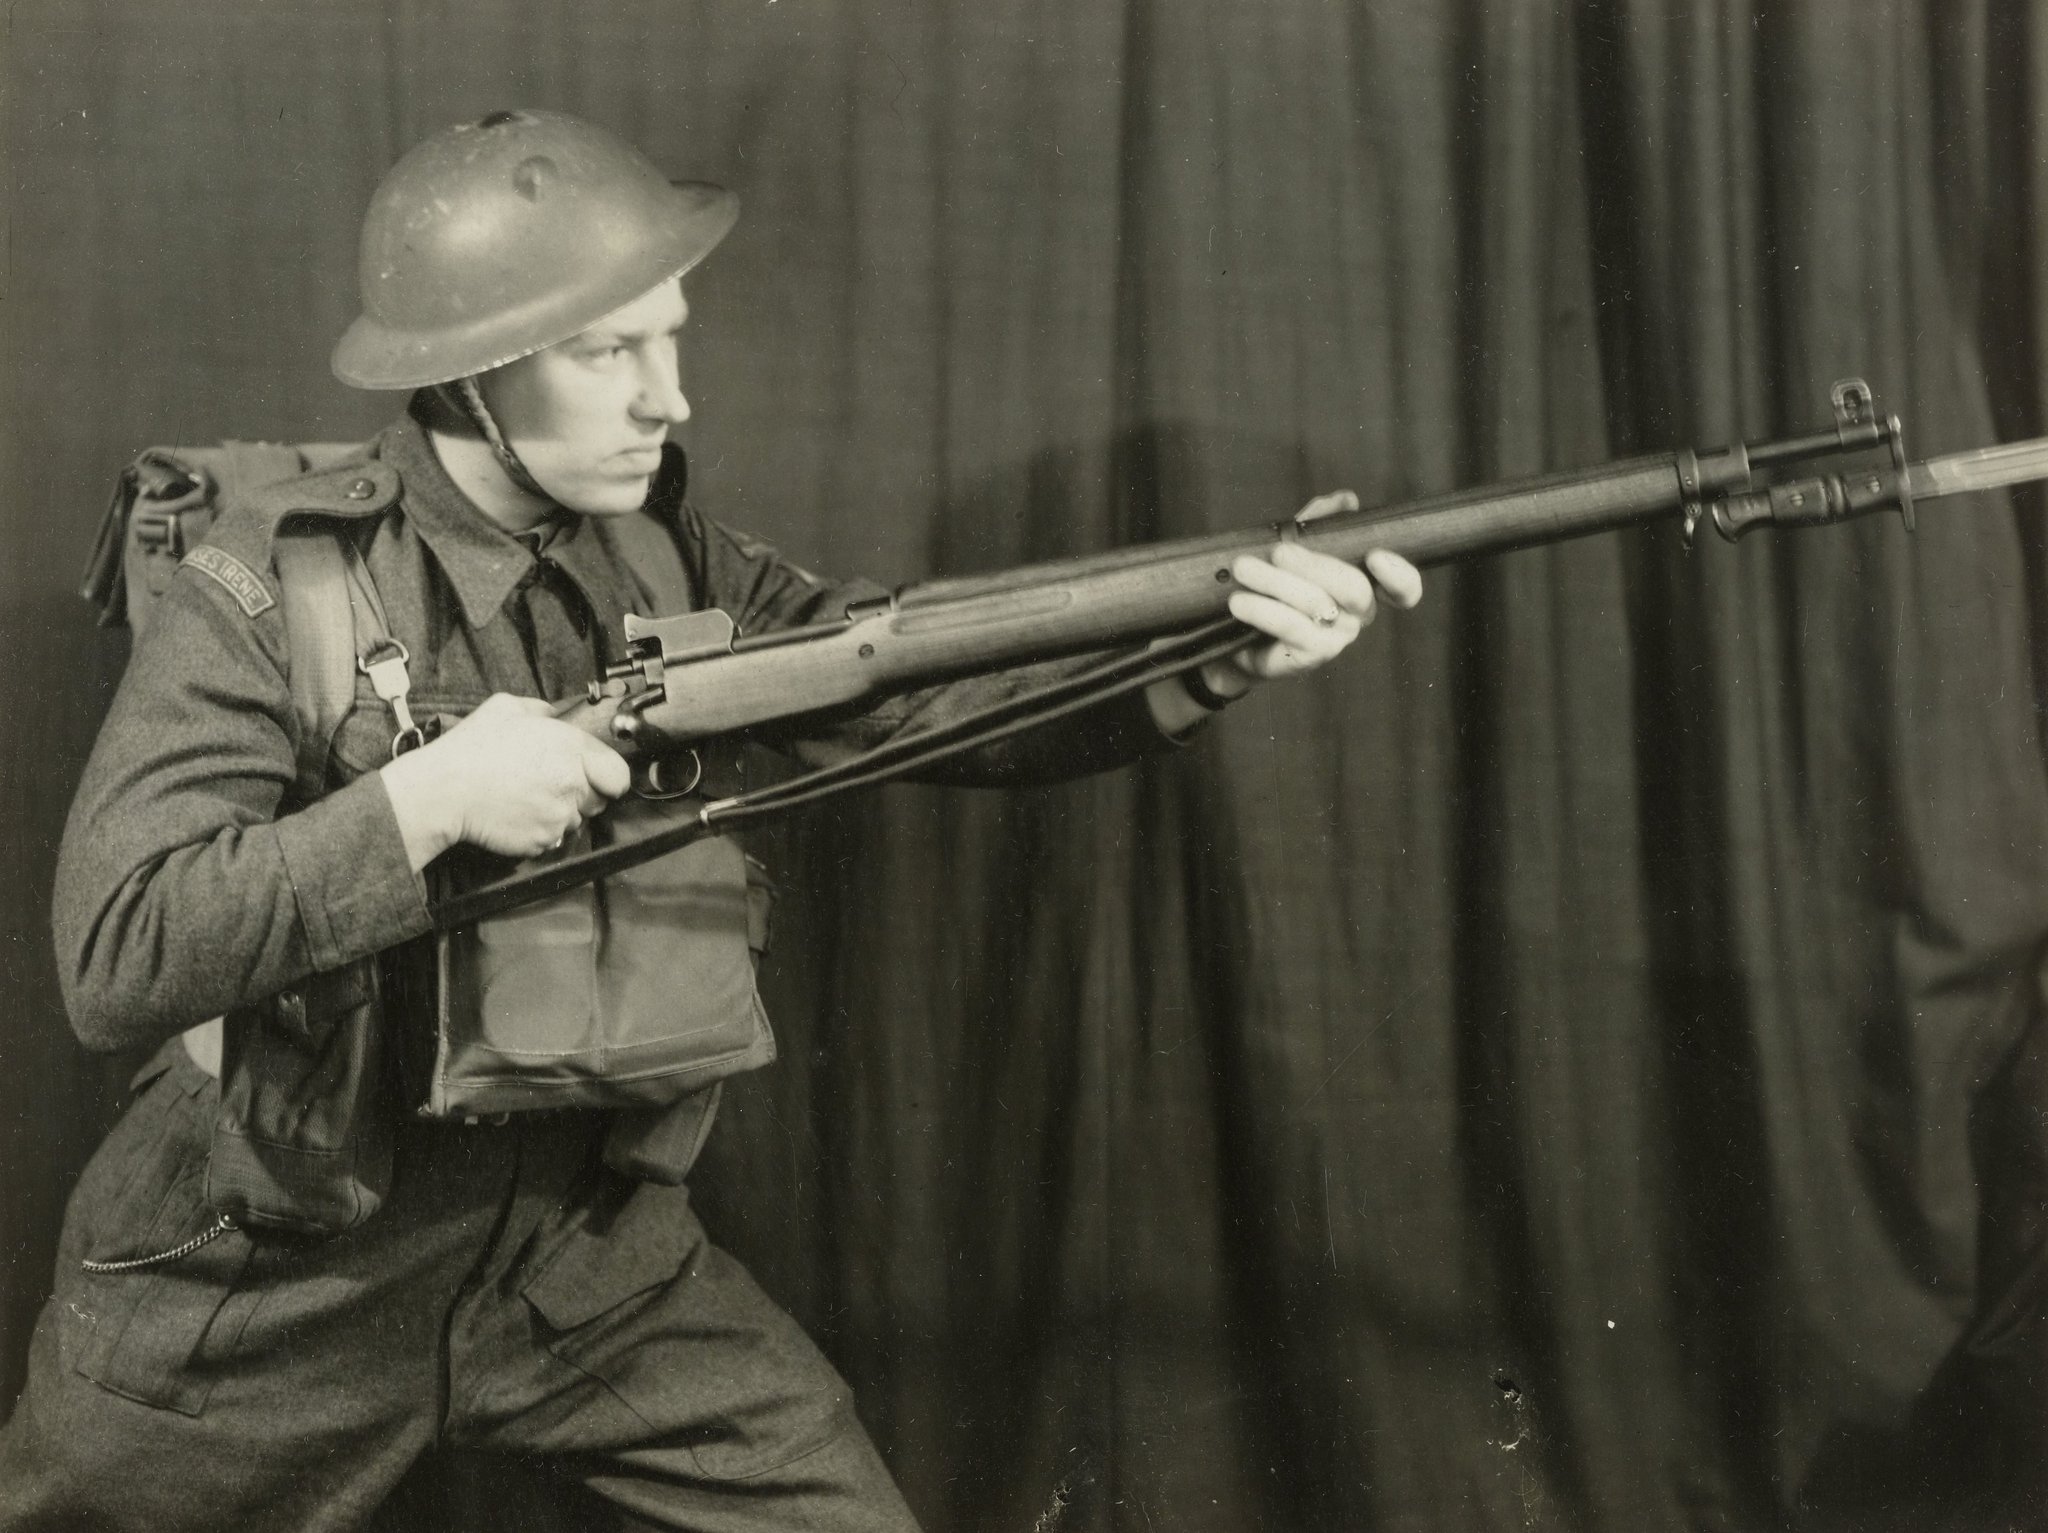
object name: photograph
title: Militair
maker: a.c. cooper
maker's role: fotograaf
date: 1940-1945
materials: photographic support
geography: london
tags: london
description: Geposeerde foto van een Nederlandse militair staand voor een gordijn. Hij richt zijn karabijn. Het onderste deel van zijn benen is niet zichtbaar. Cor Visser wilde waarschijnlijk deze foto gebruiken bij een van zijn tekeningen.